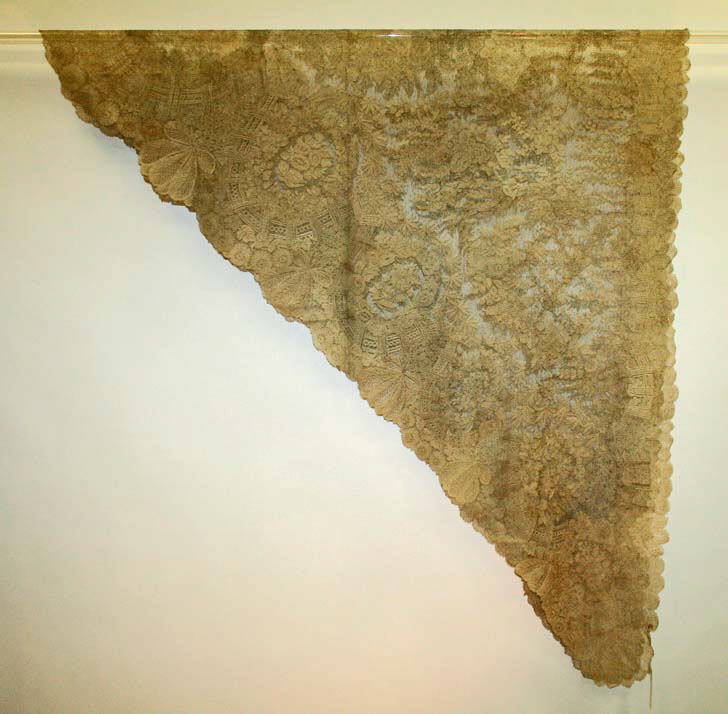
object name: shawl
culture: belgian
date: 1801-1900